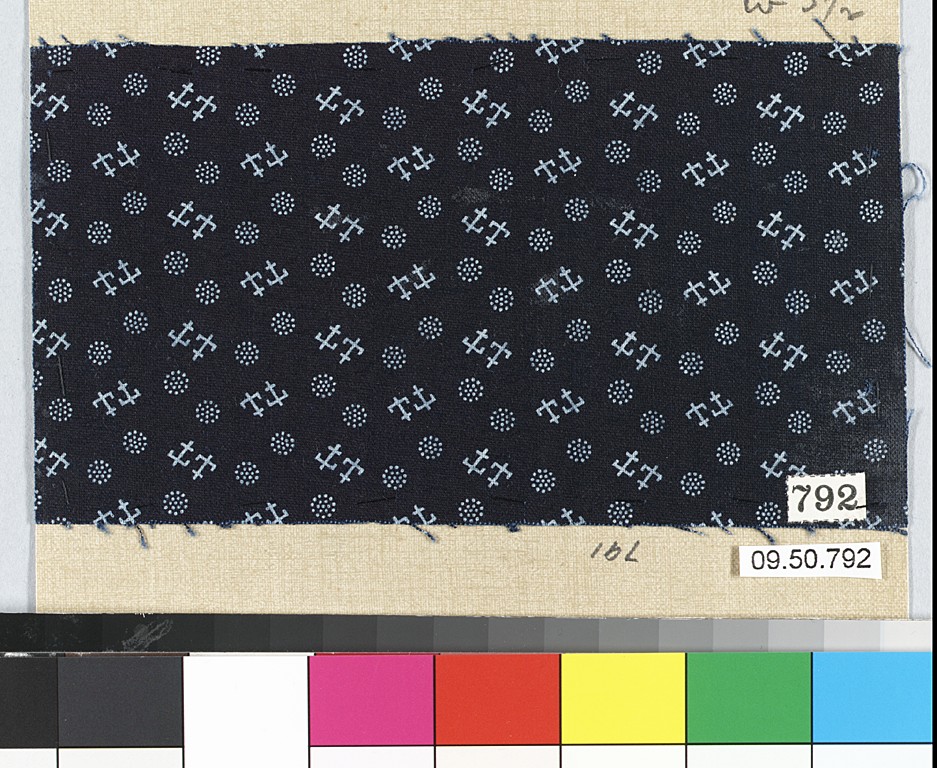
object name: piece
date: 1801-1900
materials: cotton